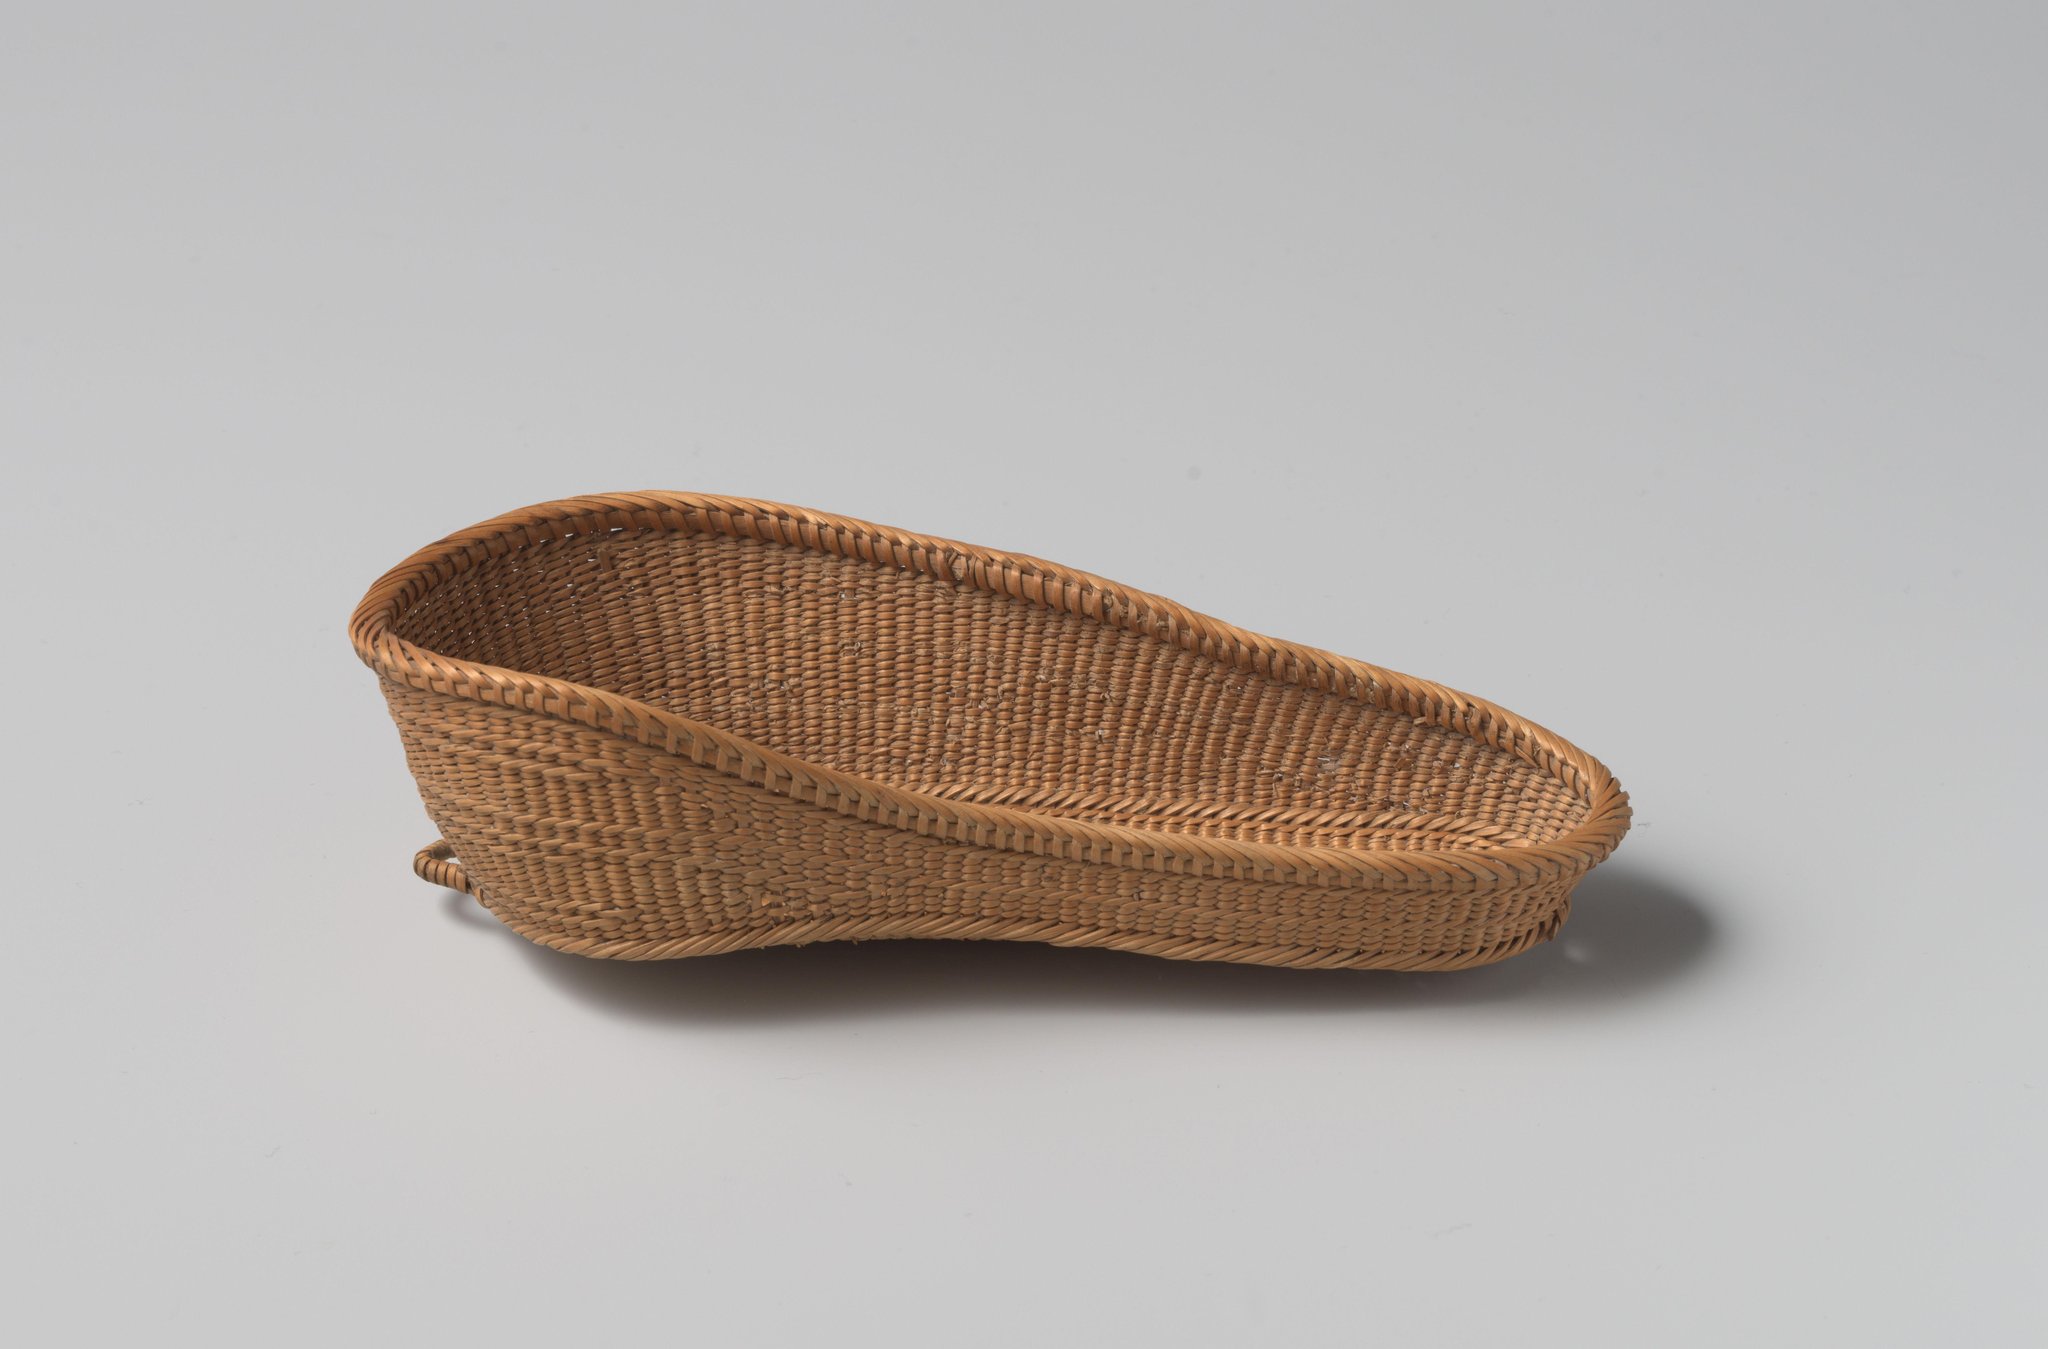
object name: bakermat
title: Bakermat van gespleten wilgenteen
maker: Anonymous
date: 1690-1710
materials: plant material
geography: halle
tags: nursing-chair (dutch: 'bakermat')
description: Bakermat bestaande uit een ovale vloermat met een opstaande rand, die aan het voeteneinde en aan één zijde wat lager blijft. De mat is gevlochten van gespleten wilgenteen en versierd met enkele ribbels.